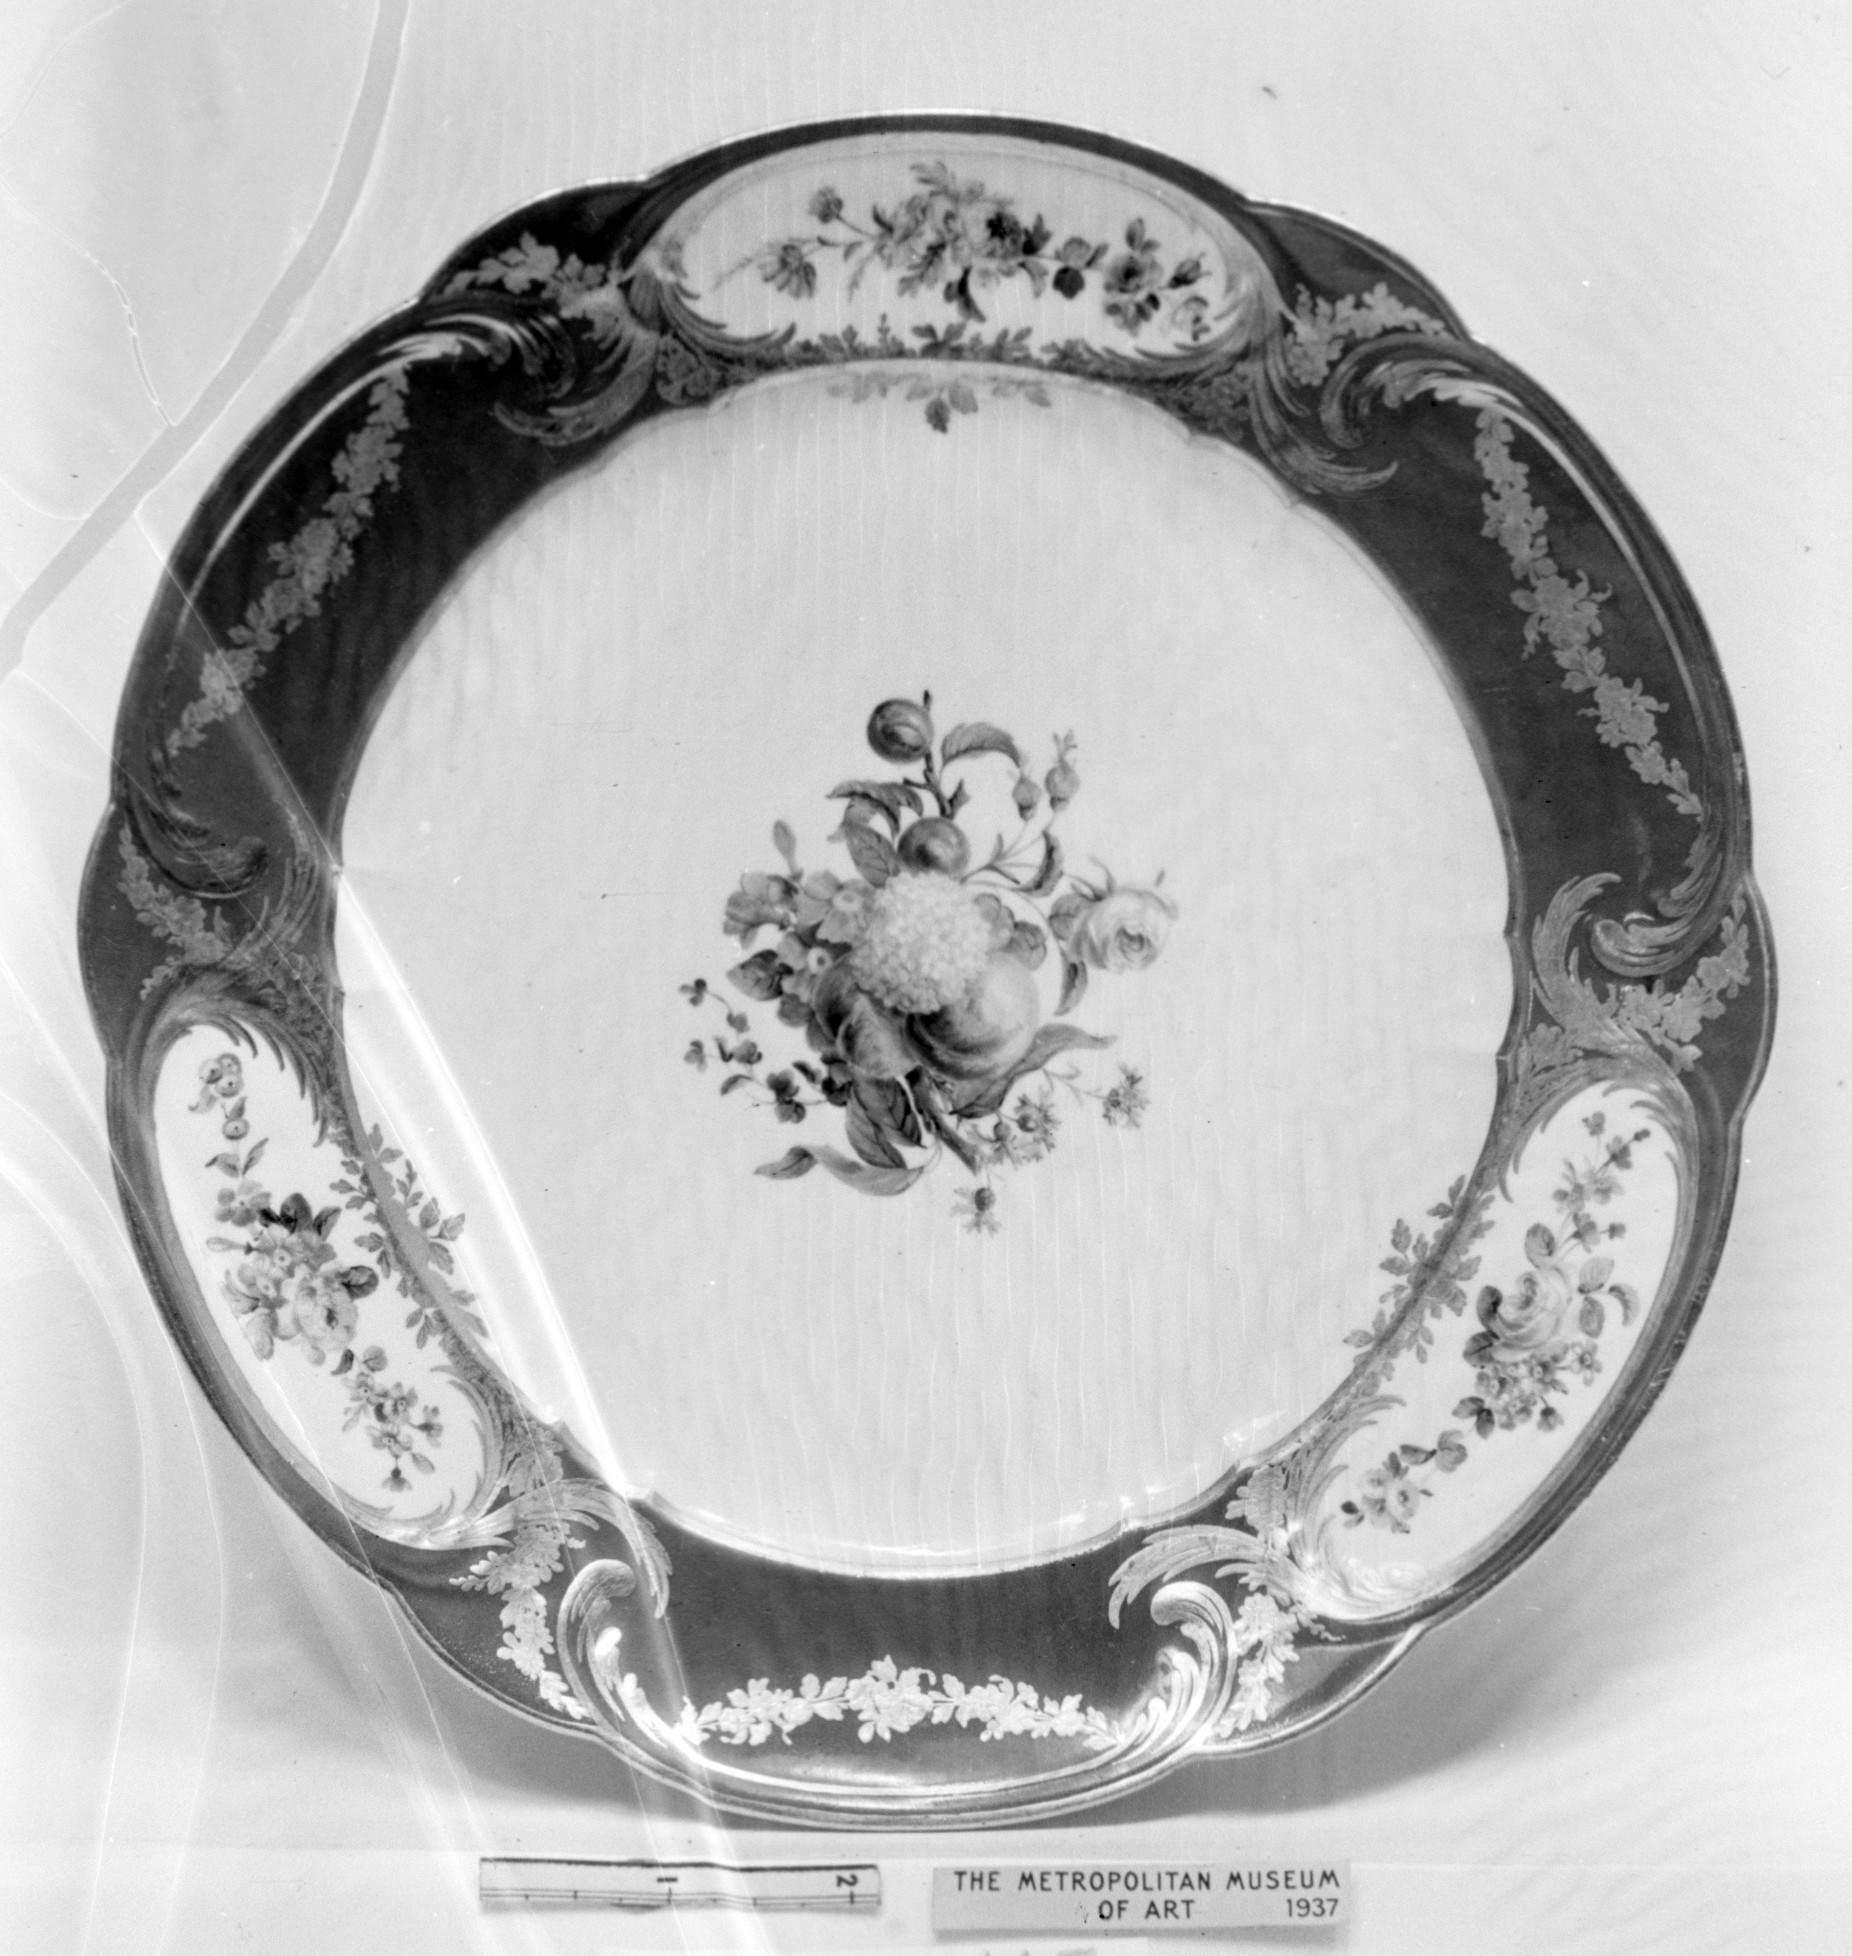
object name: plate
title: Plate (Assiette à palmes) (1 of 102) (part of a service)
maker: sèvres manufactory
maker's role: manufactory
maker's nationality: french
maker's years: 1740-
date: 1786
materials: soft paste porcelain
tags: flowers